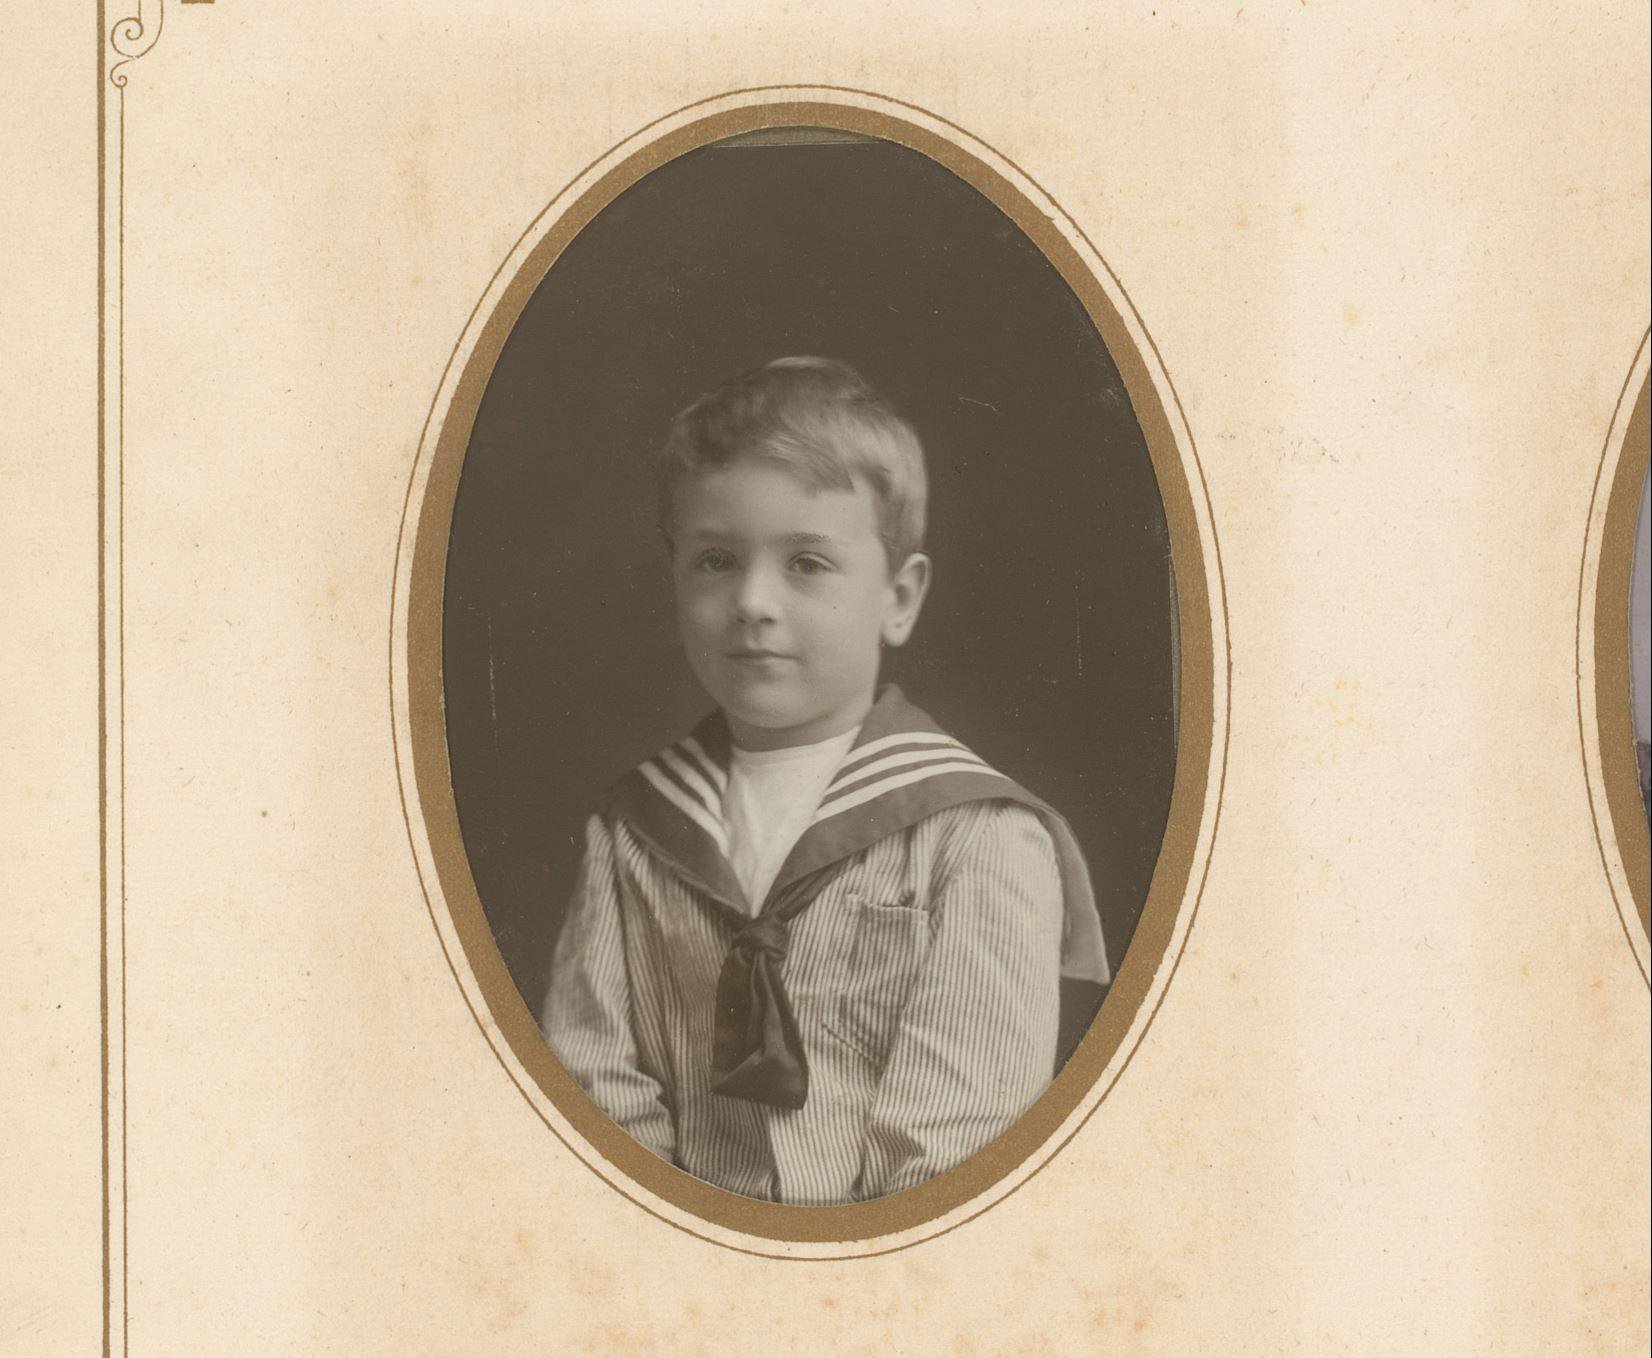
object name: carte de visite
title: Portret van een jongen in matrozenkiel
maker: antonius joannes van der stok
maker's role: fotograaf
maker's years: 1862-1941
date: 1885-1920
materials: cardboard, photographic support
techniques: collodion silver print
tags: ensemble of pieces of clothing: sailor suit, child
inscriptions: inscription: ‘Ant. J. van der Stok/ Leiden/ Breestraat 149/ (...)’